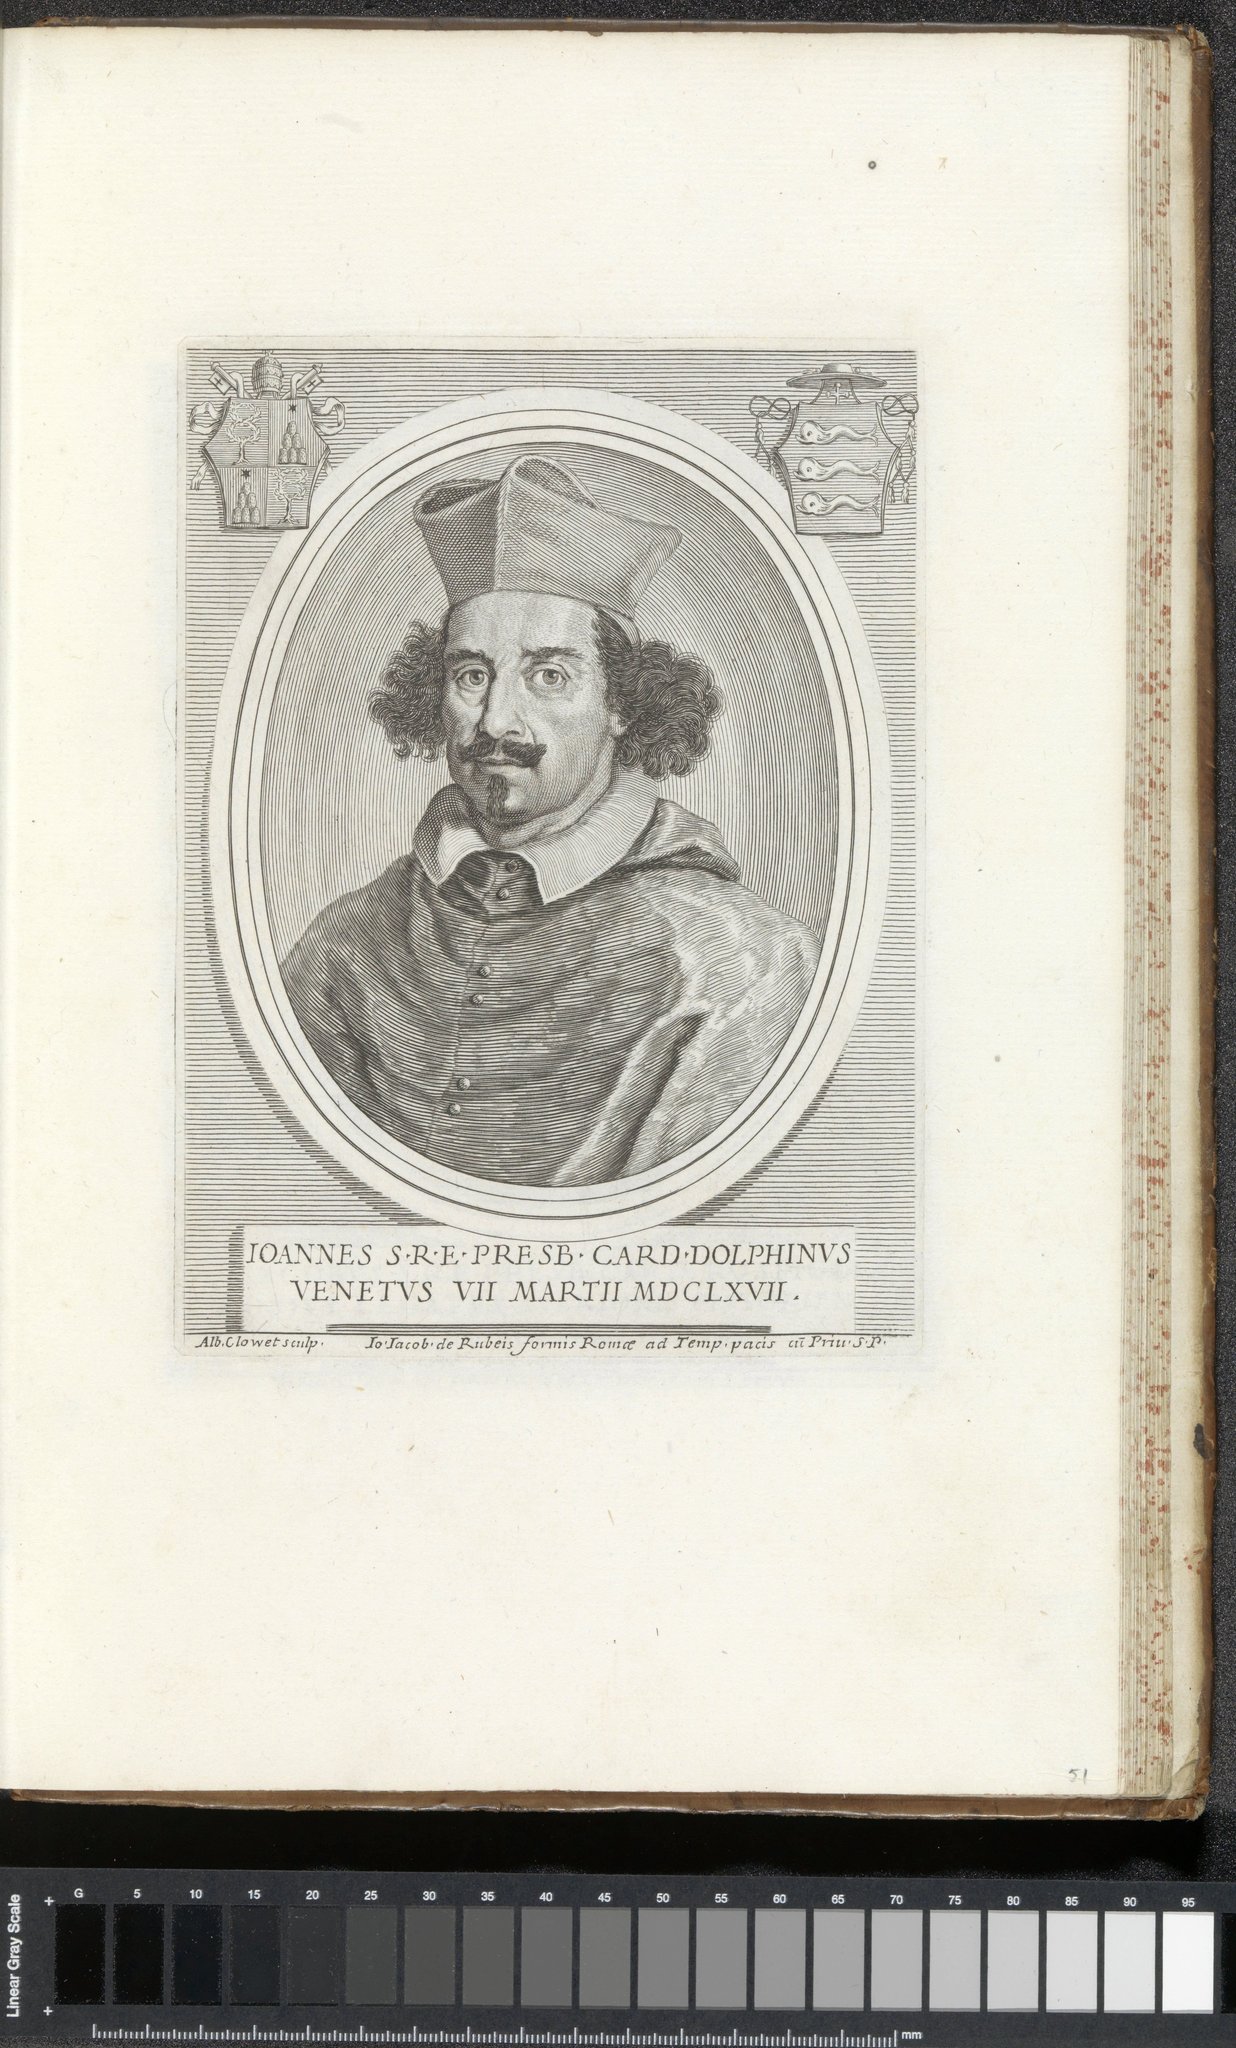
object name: print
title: Portret van kardinaal Giovanni Delfino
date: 1667-1679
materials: paper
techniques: engraving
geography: rome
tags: venice, cardinal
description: Portret van kardinaal Giovanni Delfino. Linksboven het wapen van paus Alexander VII en rechtsboven het wapen van de kardinaal. Onderaan een onderschrift in het Latijn. De prent maakt deel uit van een album.